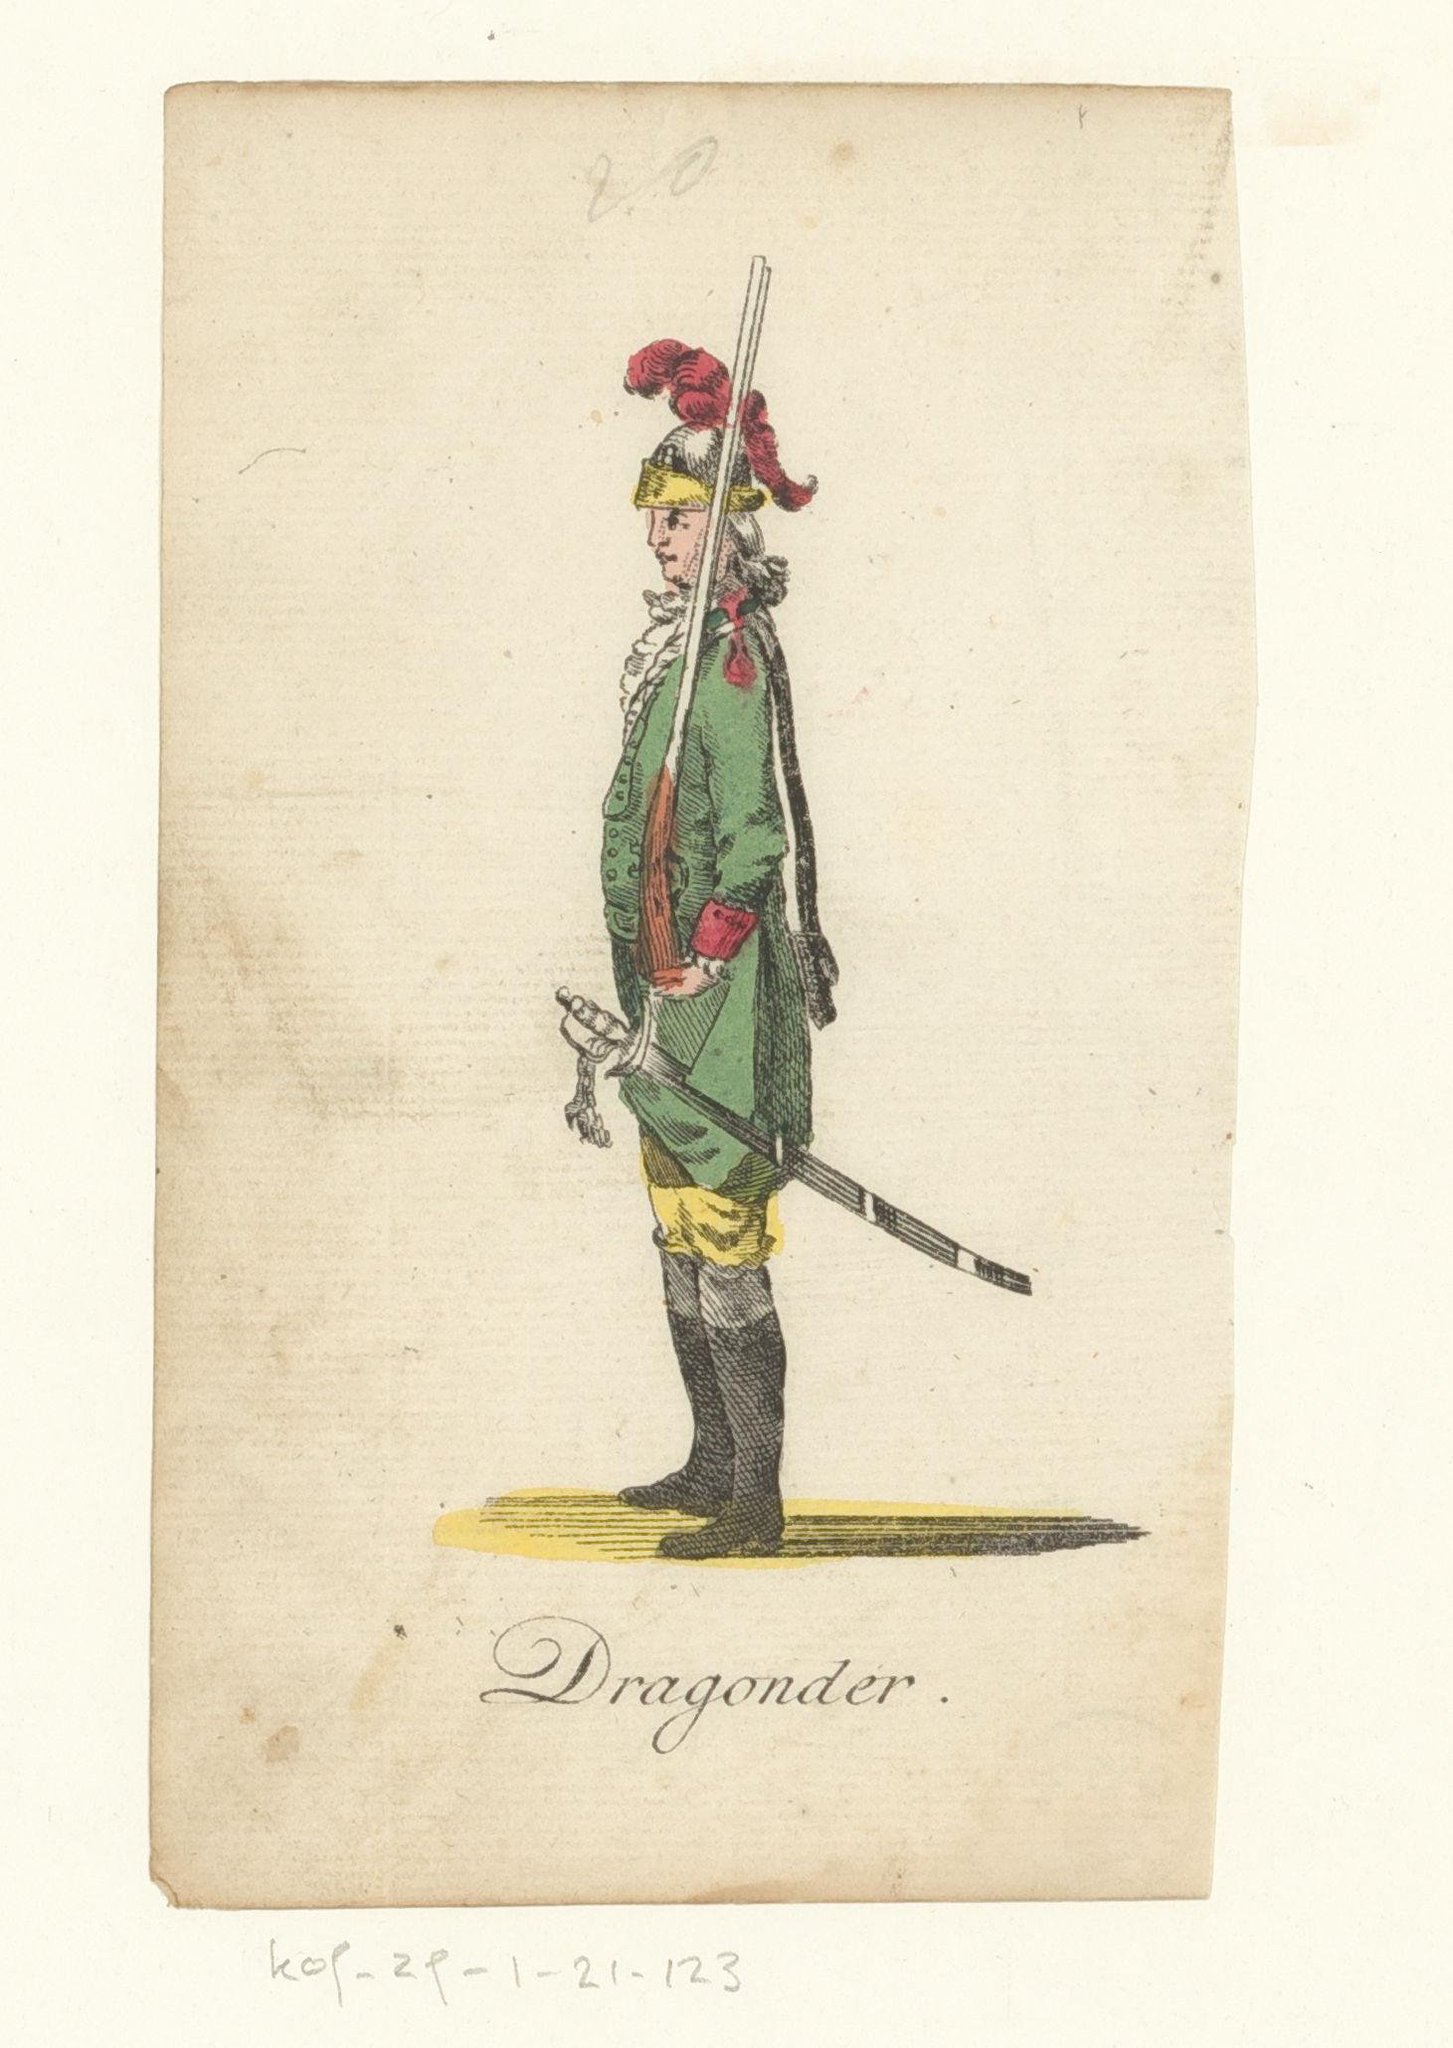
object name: print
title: Dragonder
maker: Anonymous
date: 1821-1829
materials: paper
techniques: engraving, etching, hand coloring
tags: military service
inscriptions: collector's mark: Lugt 1641a, stamp, collector's mark: Lugt 1641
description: Prent waarschijnlijk uit: Hans Beuling, of St. Nicolaas- Nieuwejaars- Vastenavond- en kermisvermaak. Voor kinderen. Rotterdam: B. Schuurling, s.a [1821-1829]. Volgens de Atlas van Stolk ook gebruikt in: De nieuwe toverlantaarn. Amsterdam: s.n., 1797.